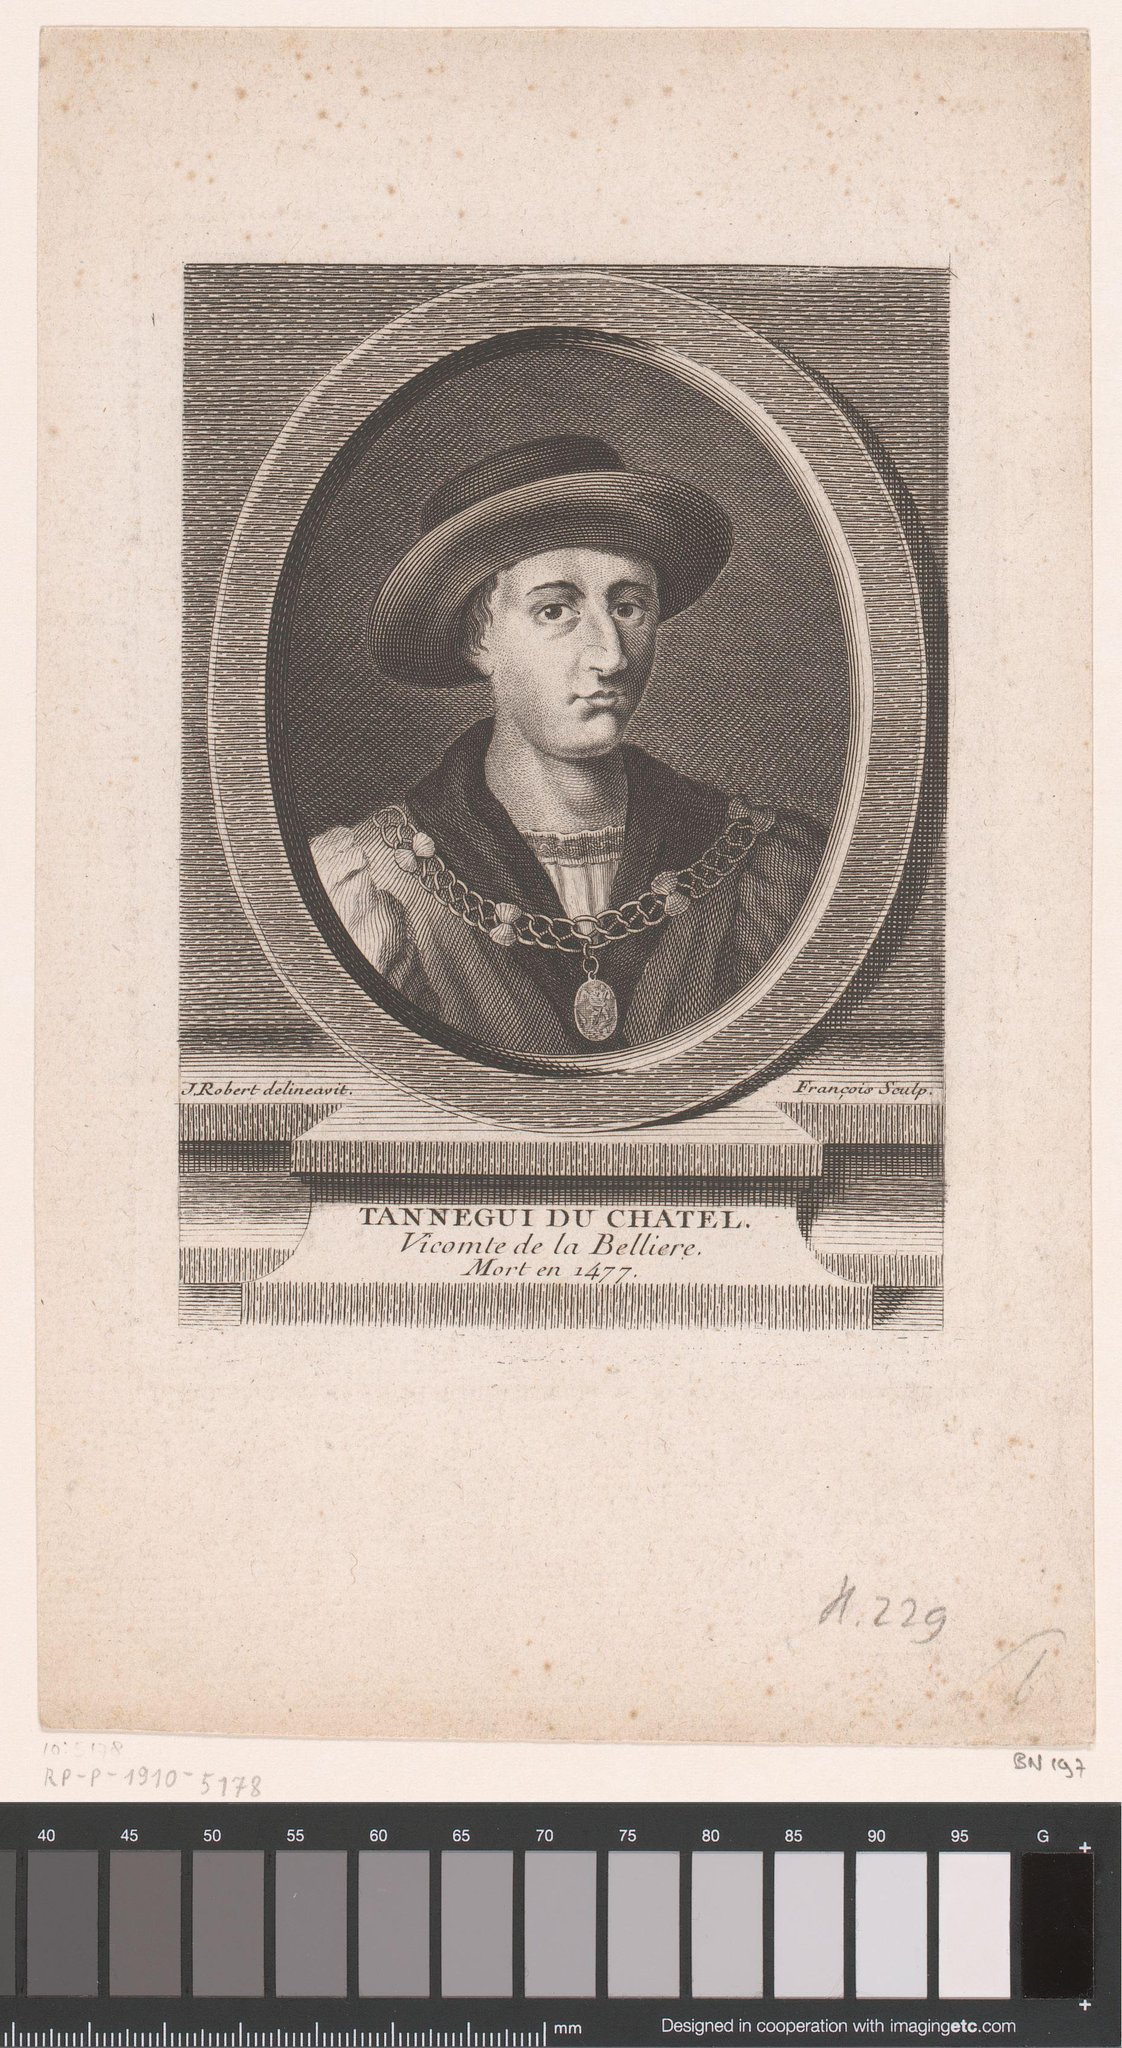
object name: book illustration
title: Portret van Tanneguy III du Chastel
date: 1755-1765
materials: paper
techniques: engraving, etching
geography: france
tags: historical persons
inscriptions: collector's mark: Lugt 2228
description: Prent uit: Dreux du Radier, Jean-François. L'Europe illustré, contenant l'histoire abregée des souverains, des princes, des prélats, des ministres, (...) en Europe: dans le XVe. siècle compris, jusqu'à présent. Parijs: Michel Odieuvre en Jean-Luc Nyon, 1755-1765.